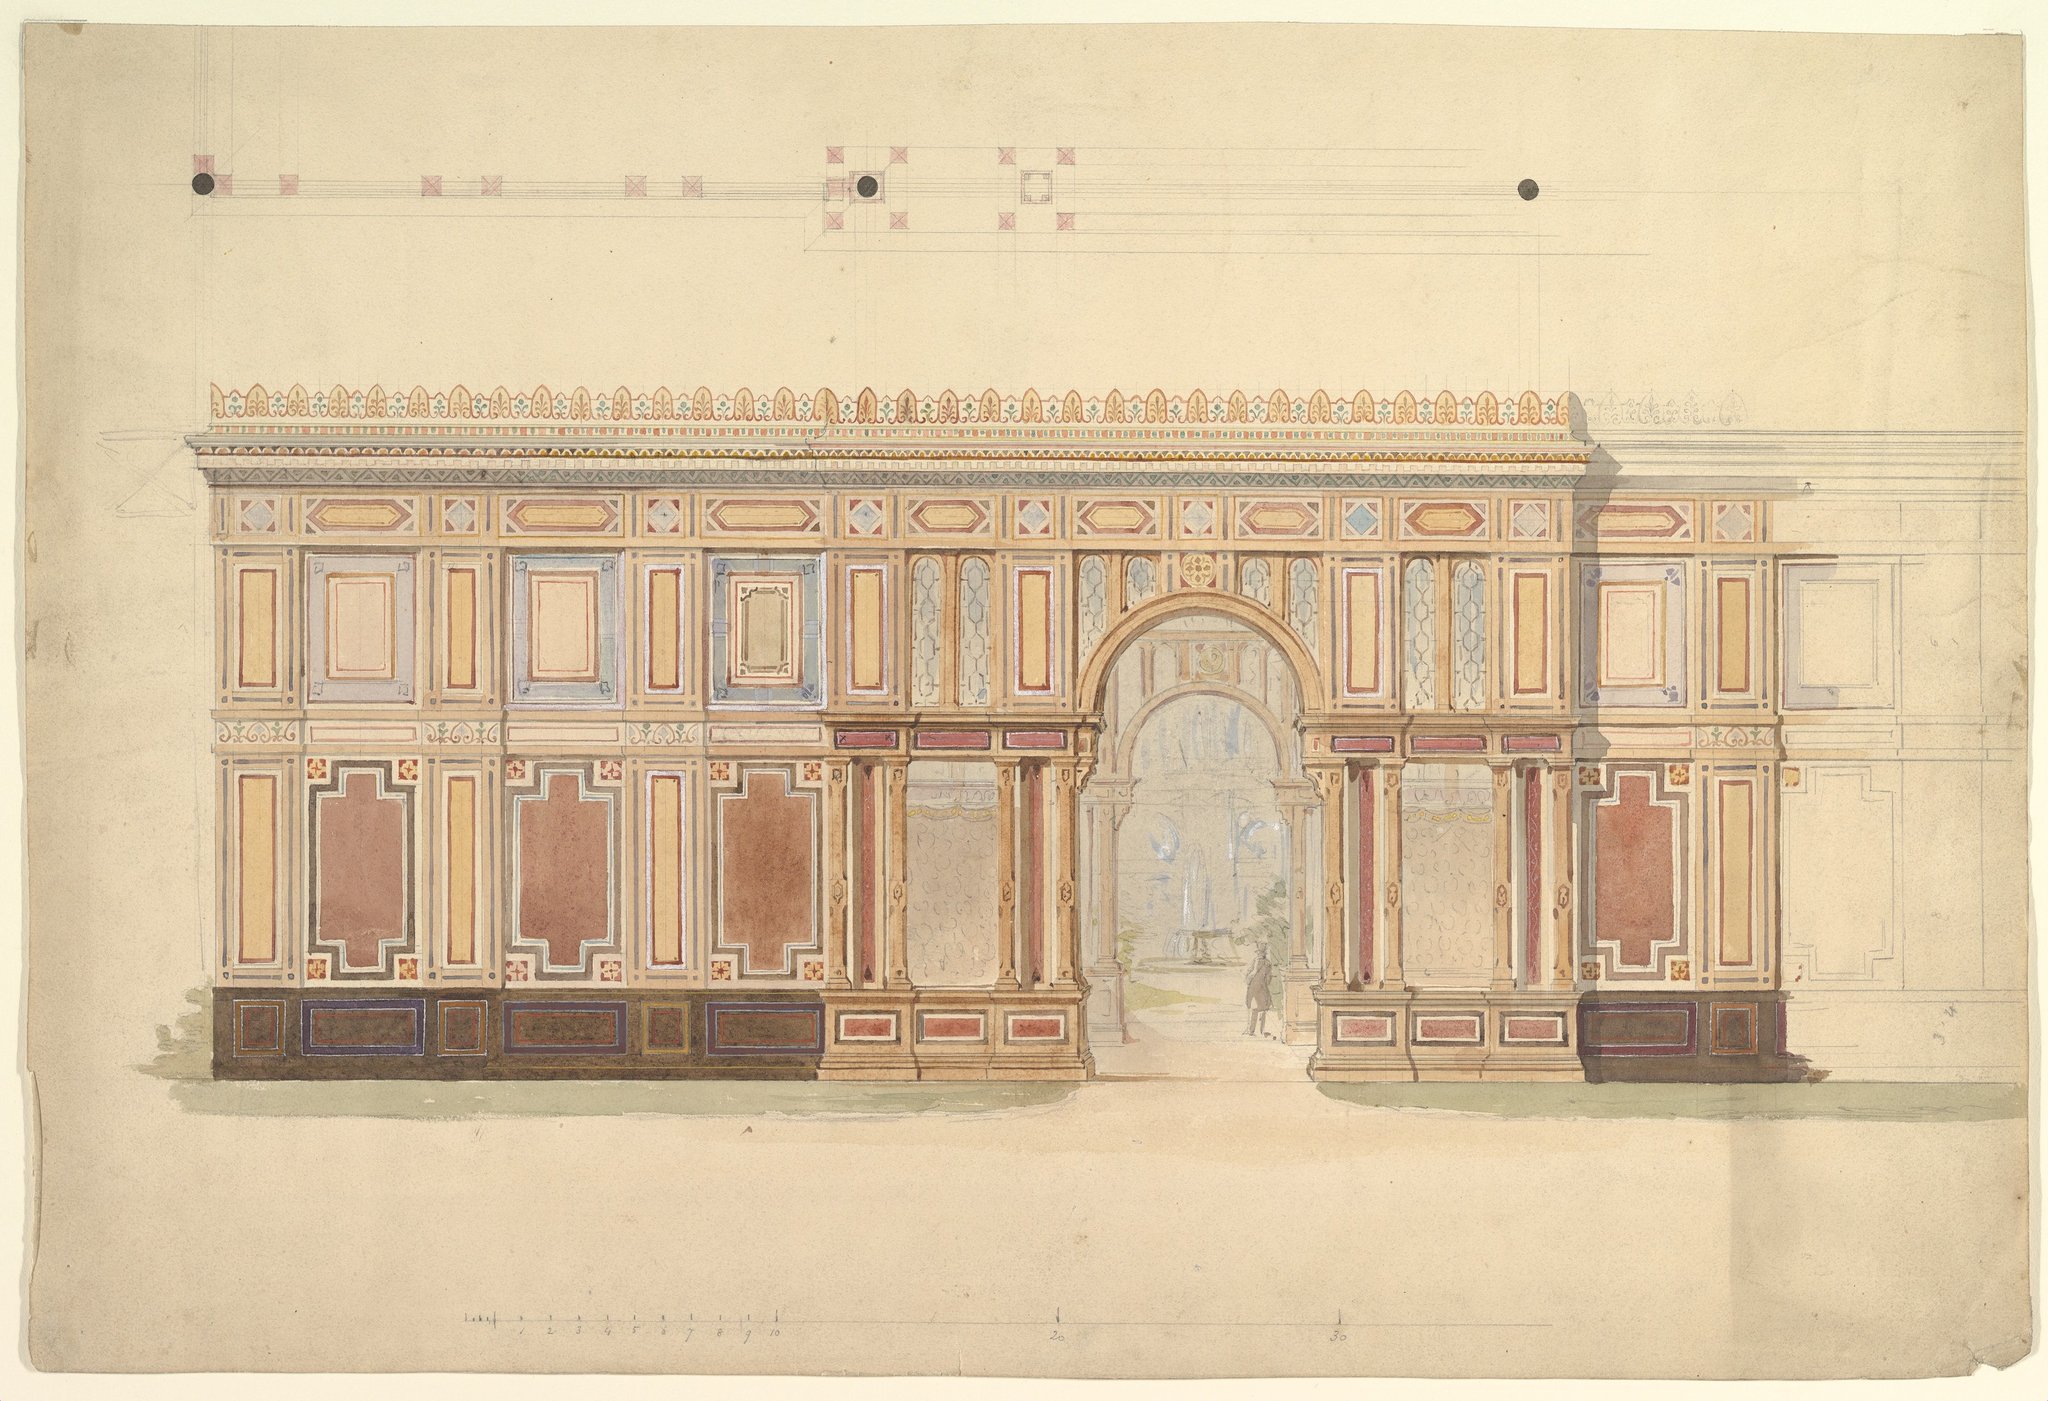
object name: drawing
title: Elevation and Cross-Section of of Gallery Wall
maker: john gregory crace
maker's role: artist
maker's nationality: british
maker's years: 1809-1889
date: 1801-1900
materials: graphite, watercolor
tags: architecture